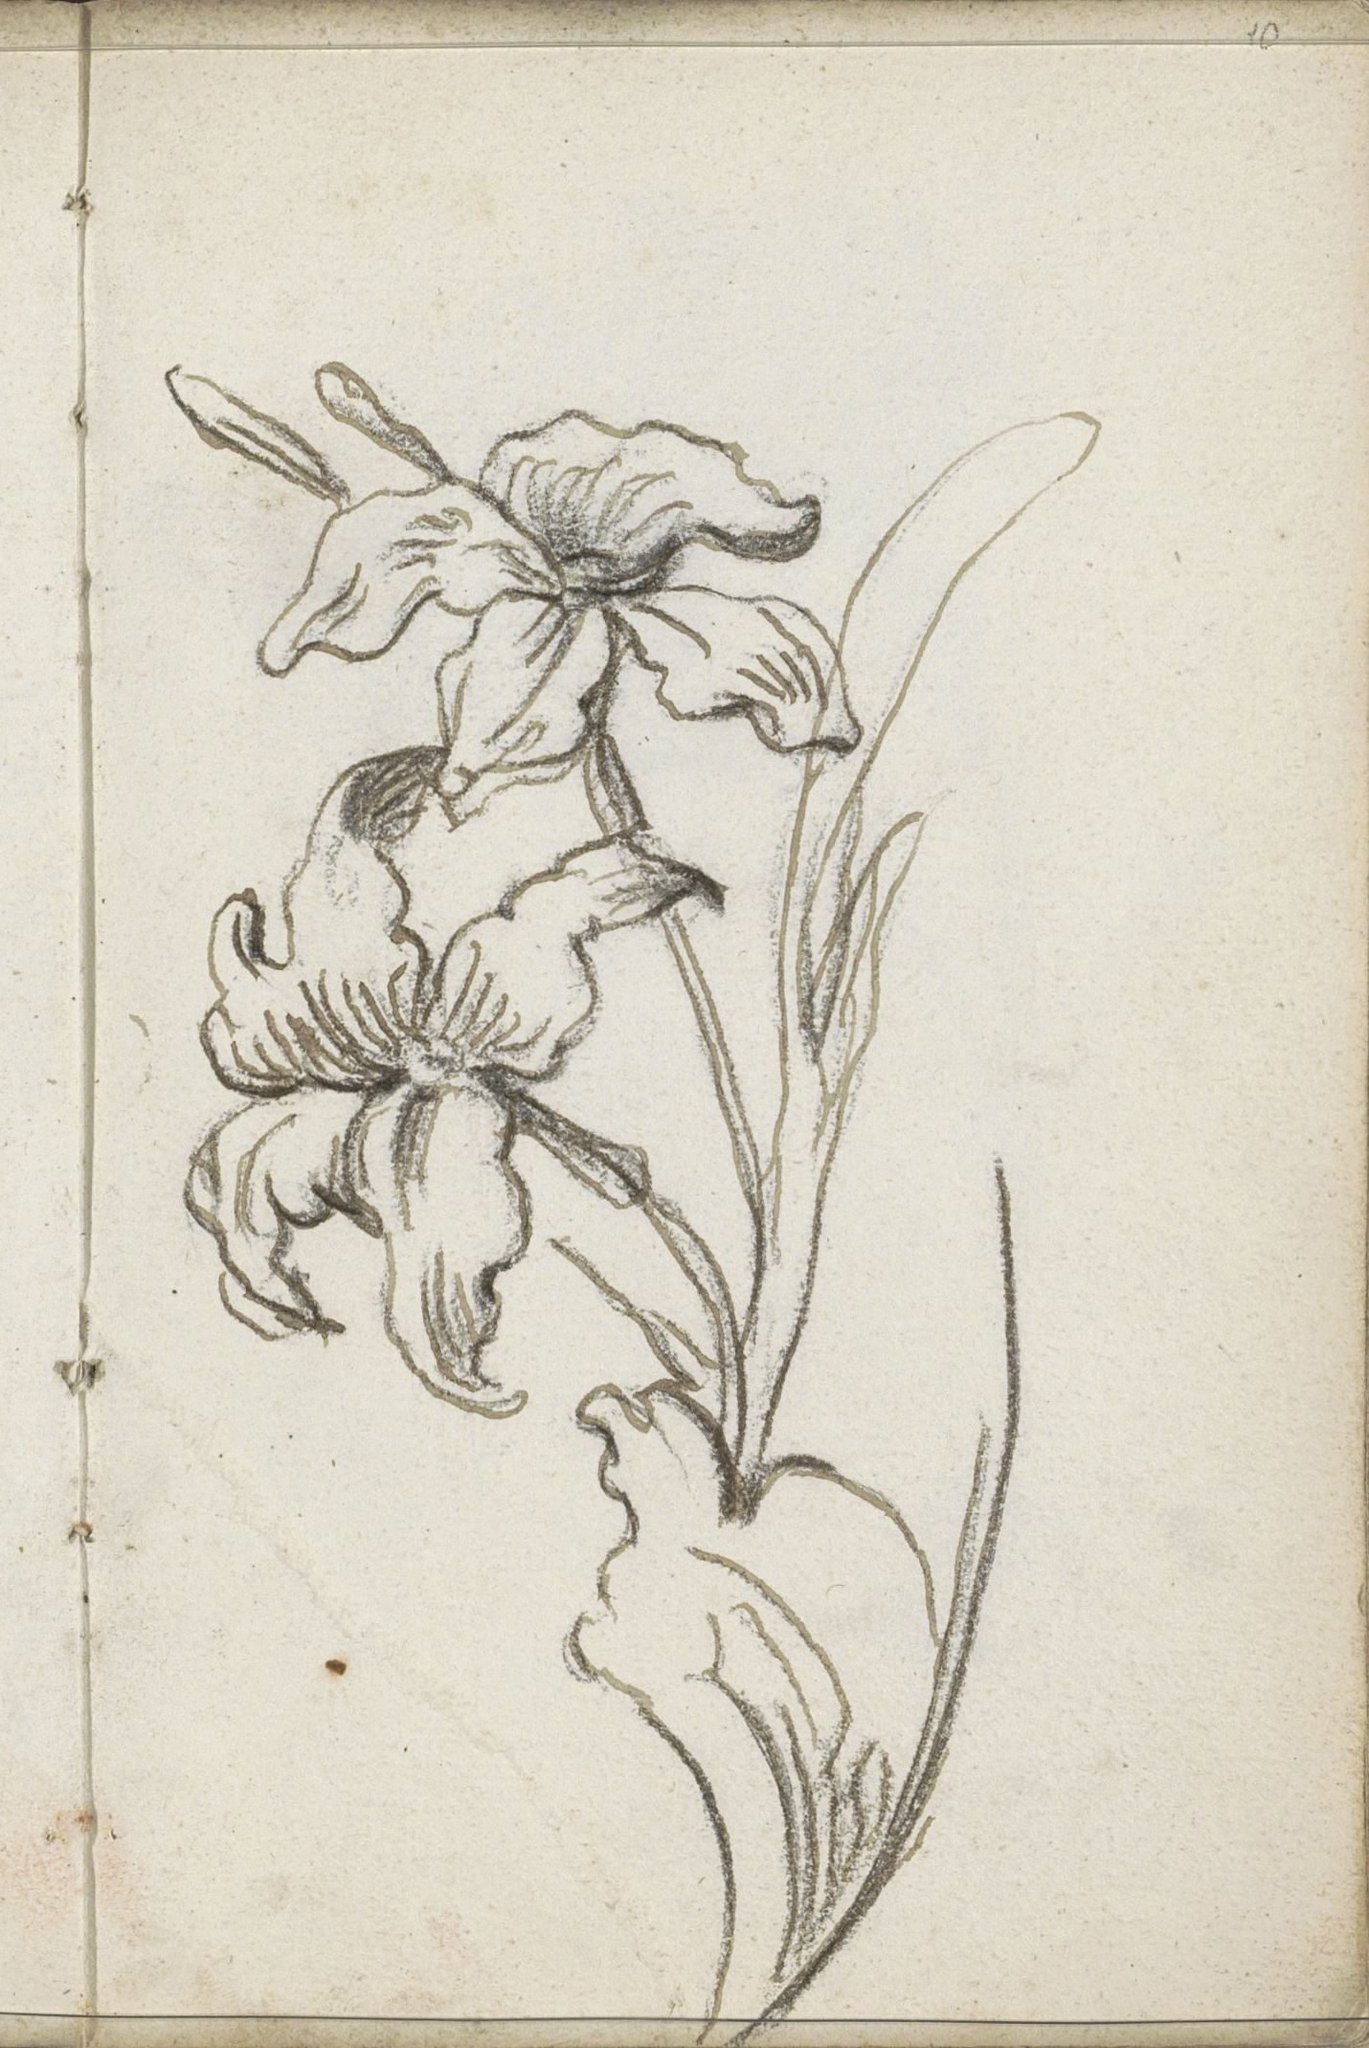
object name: sketchbook leaf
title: Bloemen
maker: petrus johannes van reysschoot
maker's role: draughtsman, print maker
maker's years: 1702-1772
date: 1710-1772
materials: chalk, ink, paper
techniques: pen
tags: flowers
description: Blad 10 recto uit een schetsboek met 105 bladen.